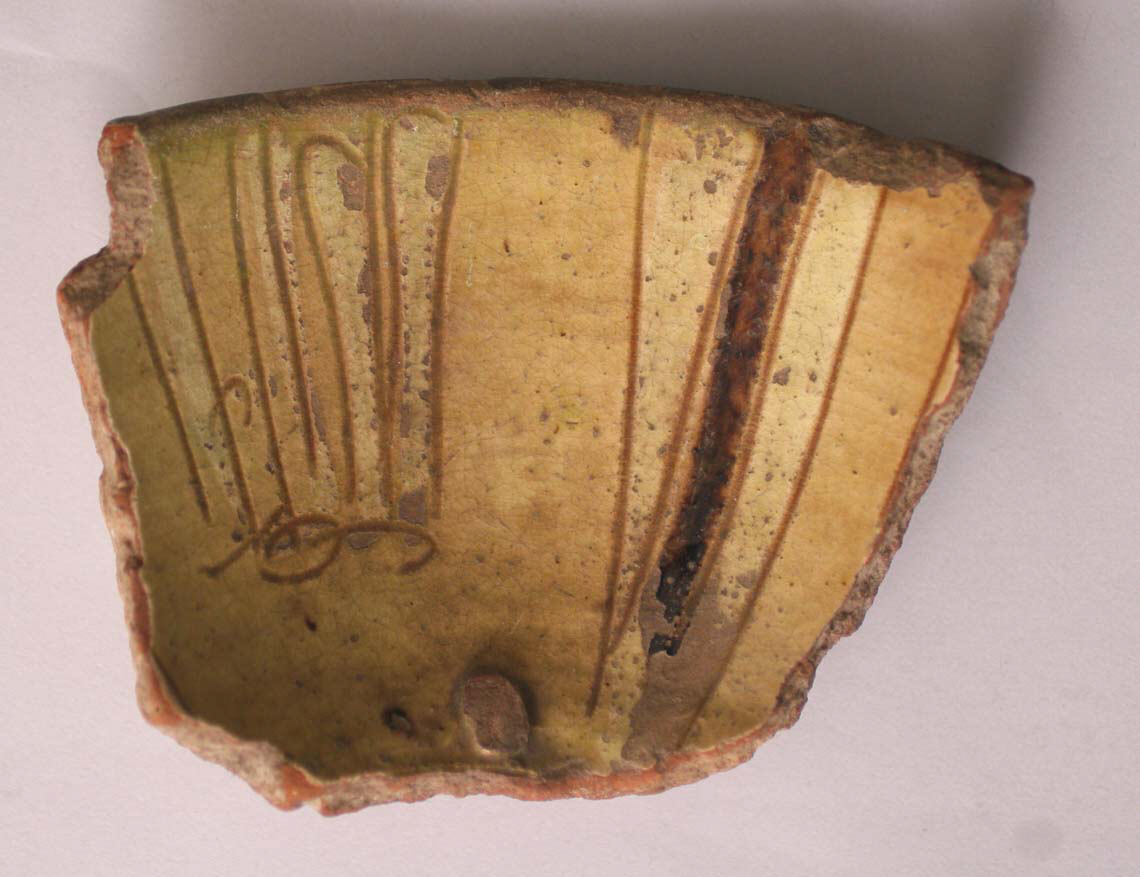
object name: ceramic fragment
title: Fragment of a Bowl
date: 1301-1500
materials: earthenware, glaze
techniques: coloring, incising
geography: egypt